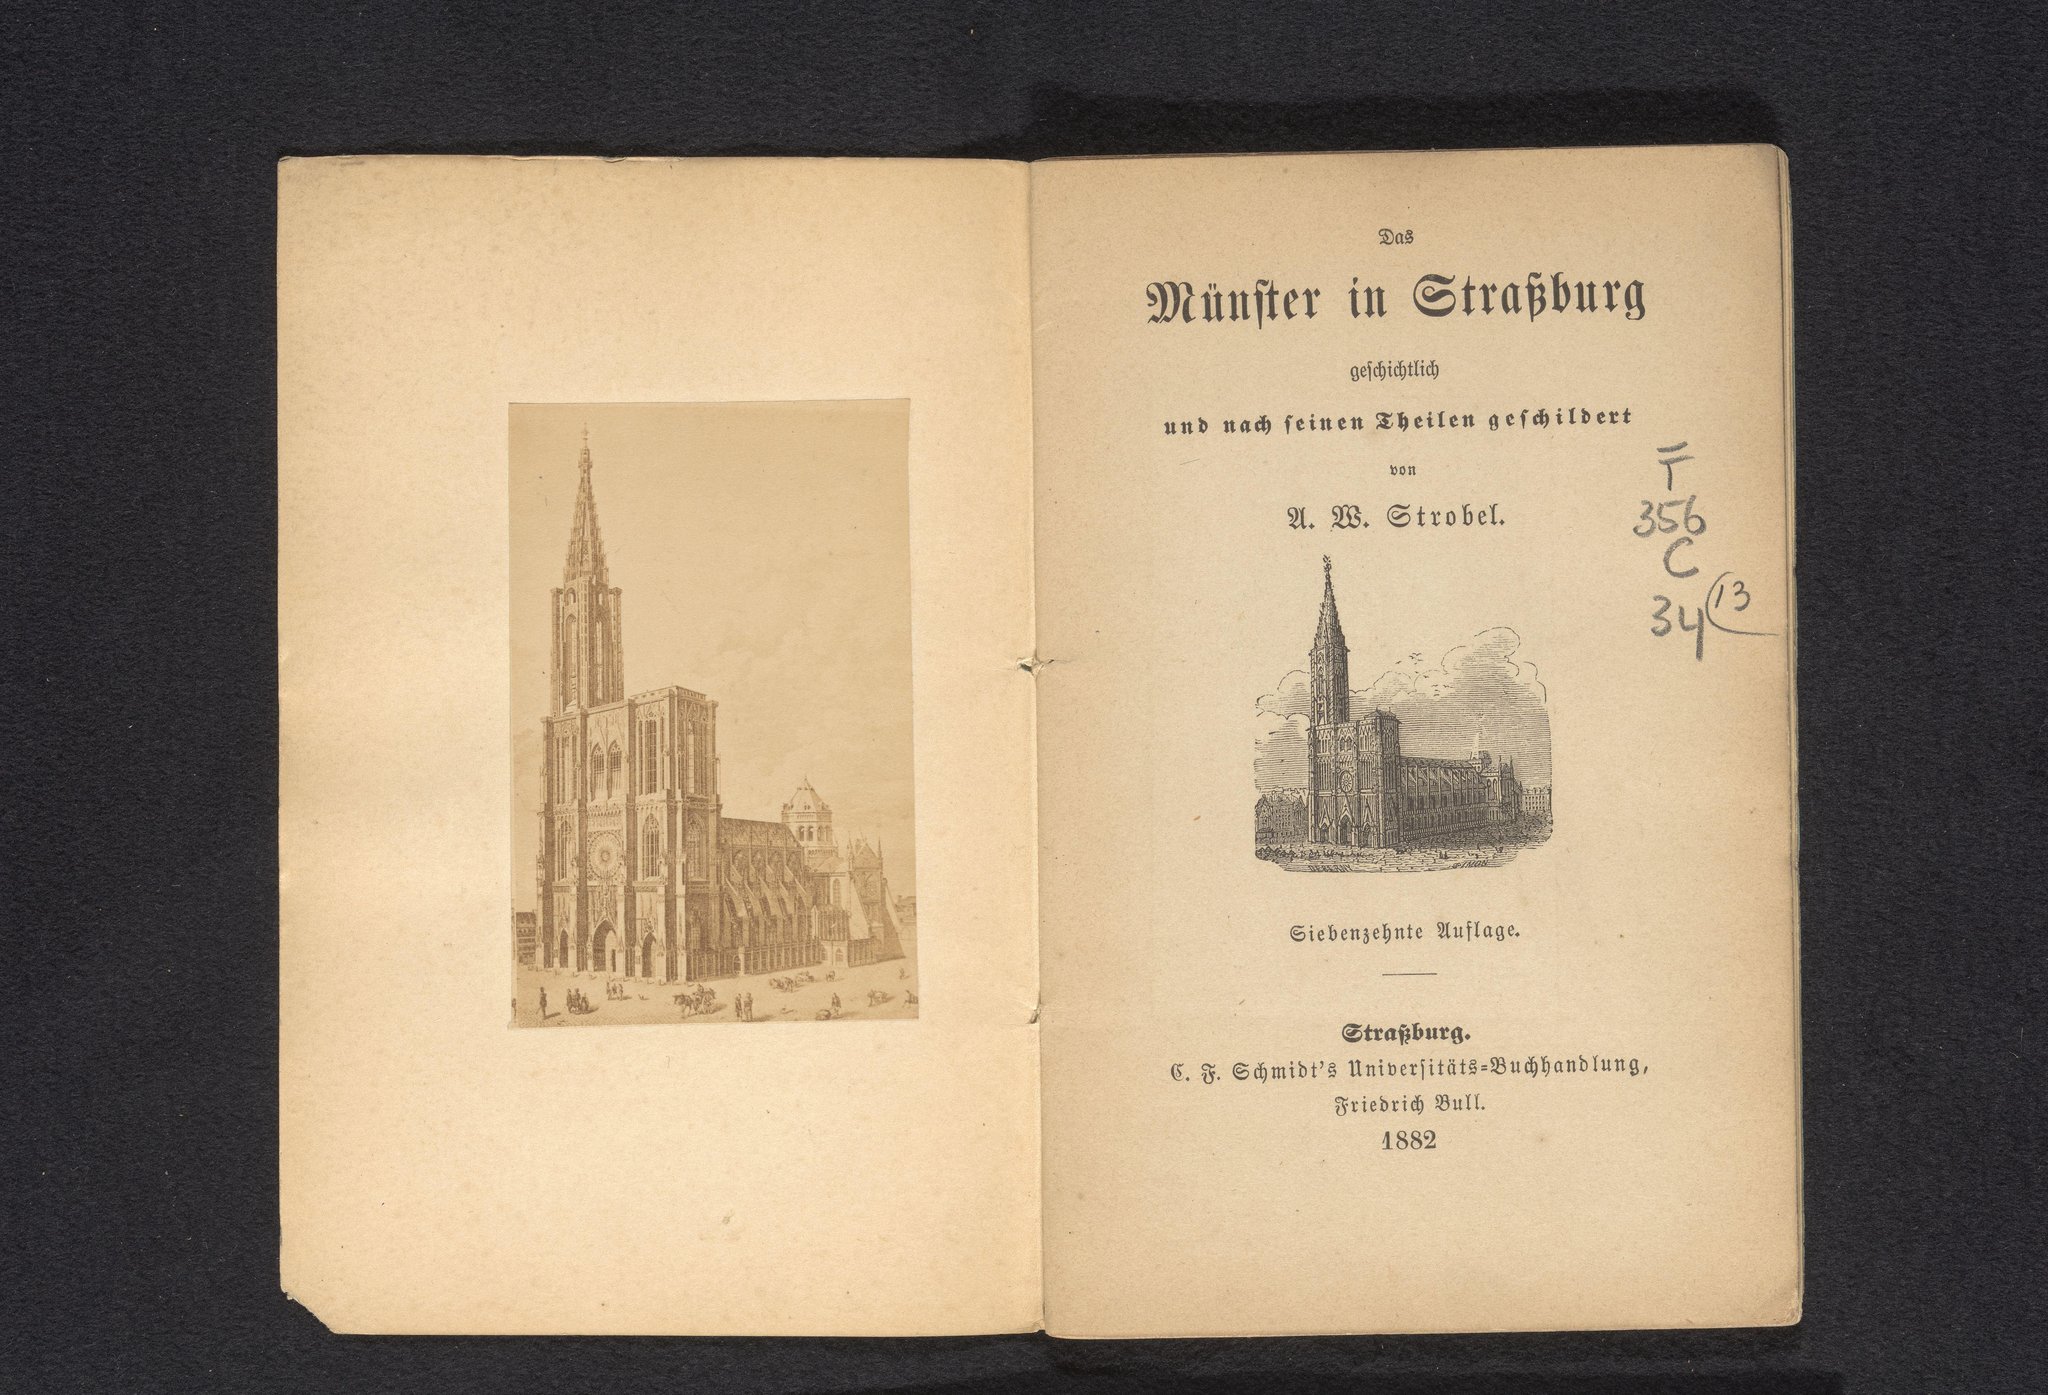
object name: book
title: Das Münster in Strassburg geschichtlich und nach seinen Theilen geschildert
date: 1882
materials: paper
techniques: albumen print, printing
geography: straatsburg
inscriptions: inscription: ‘ex N 1993’, inscription: ‘453e’